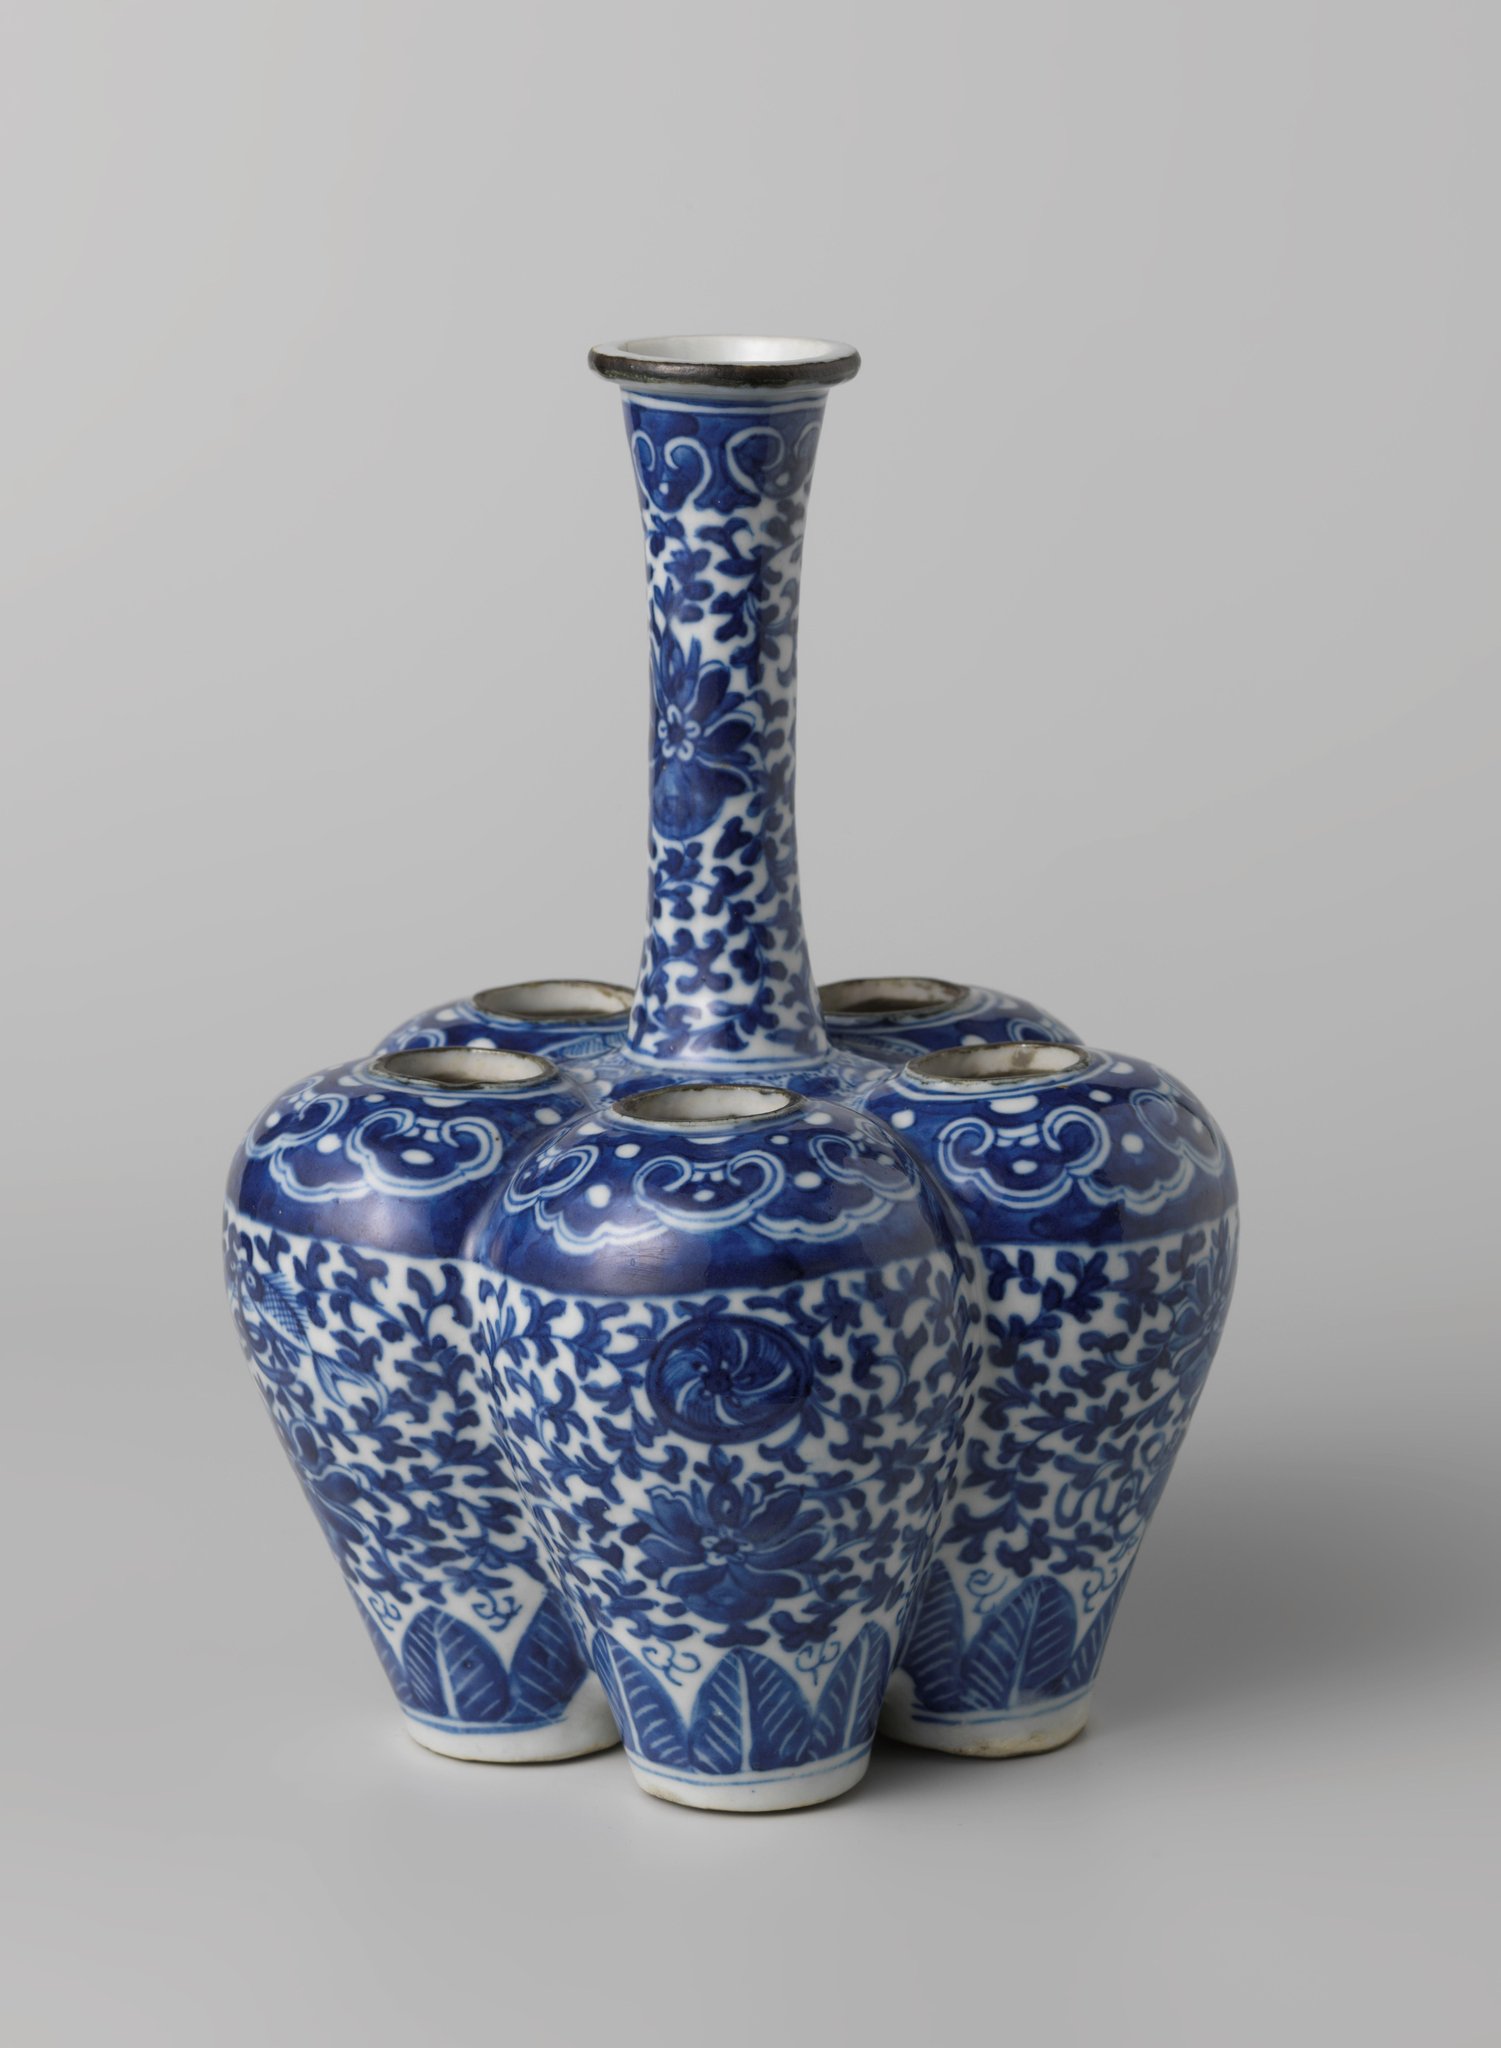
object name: vase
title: Lobed vase with floral scrolls and auspicious symbols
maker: Anonymous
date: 1850-1899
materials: cobalt, glaze, paint, porcelain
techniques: firing, forming, turning, vitrification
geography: china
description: Vijfmaal gelobde vaas van porselein met een lange, smalle, iets uitlopende nek, beschilderd in onderglazuur blauw. In elk van de vijf bollingen een opening aan de bovenzijde. Het lichaam en de hals met bloemranken; op elke bolling twee gelukssymbolen (vissen, lotus, parasol, oneindige knoop, chakra). De onderzijde van het lichaam met een band met bladmotieven. Op de schouder en de rand een band met ruyi-motieven. Blauw-wit.